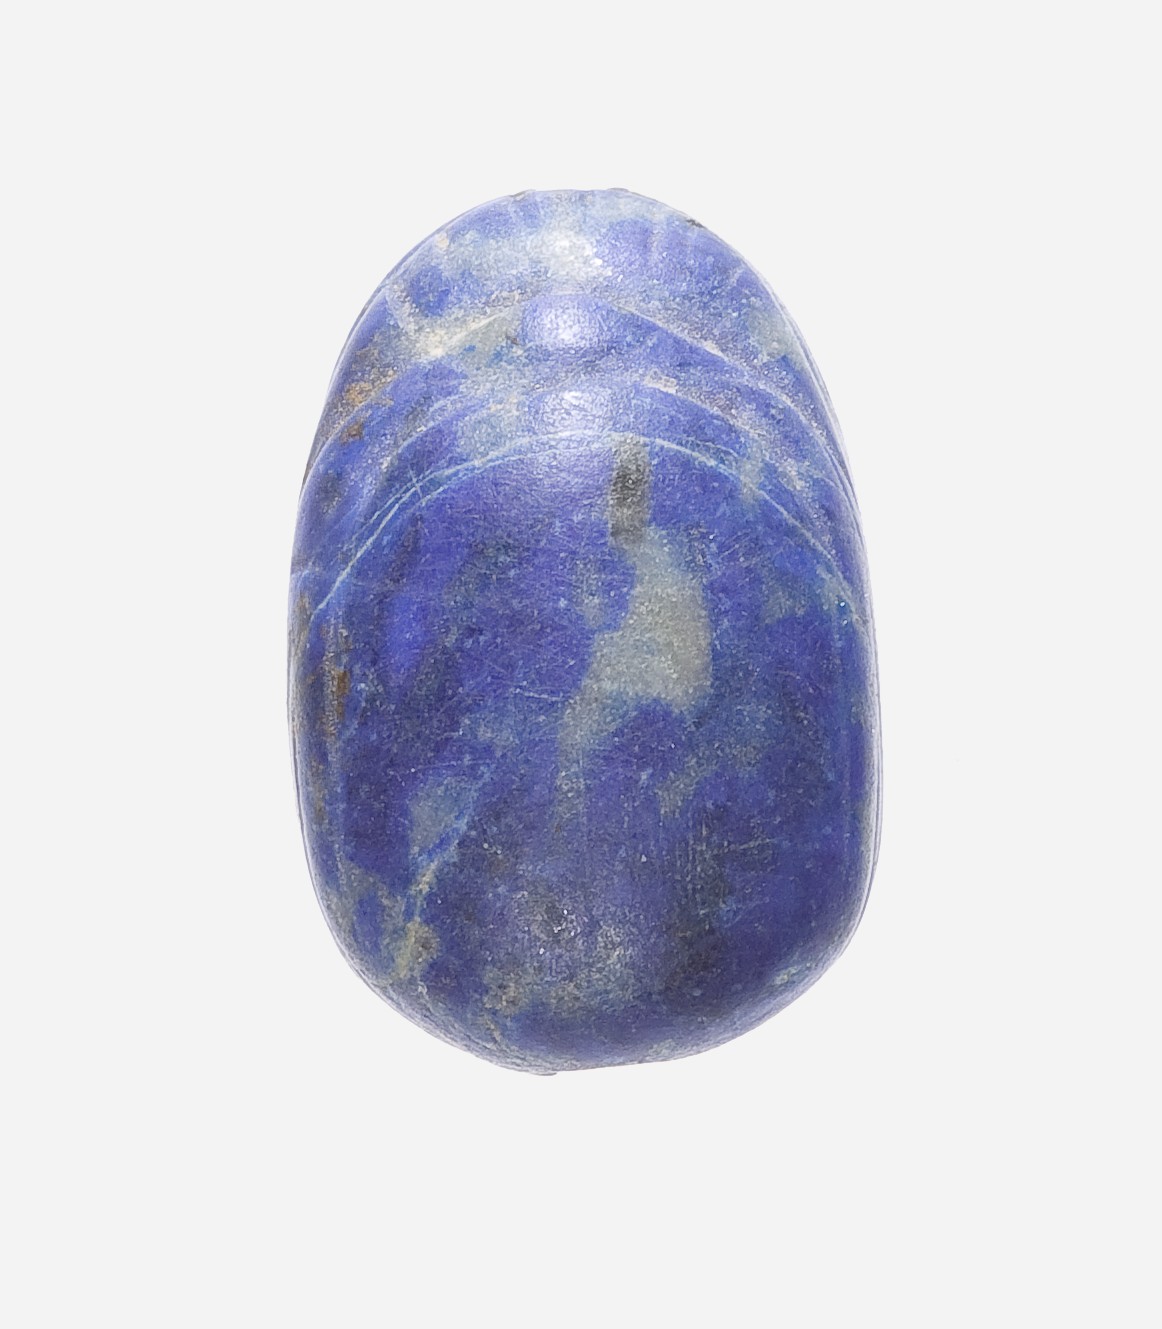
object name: scarab with remains of ring wire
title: Scarab from a Ring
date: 1850-1775 BCE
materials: lapis lazuli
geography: egypt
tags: scarabs